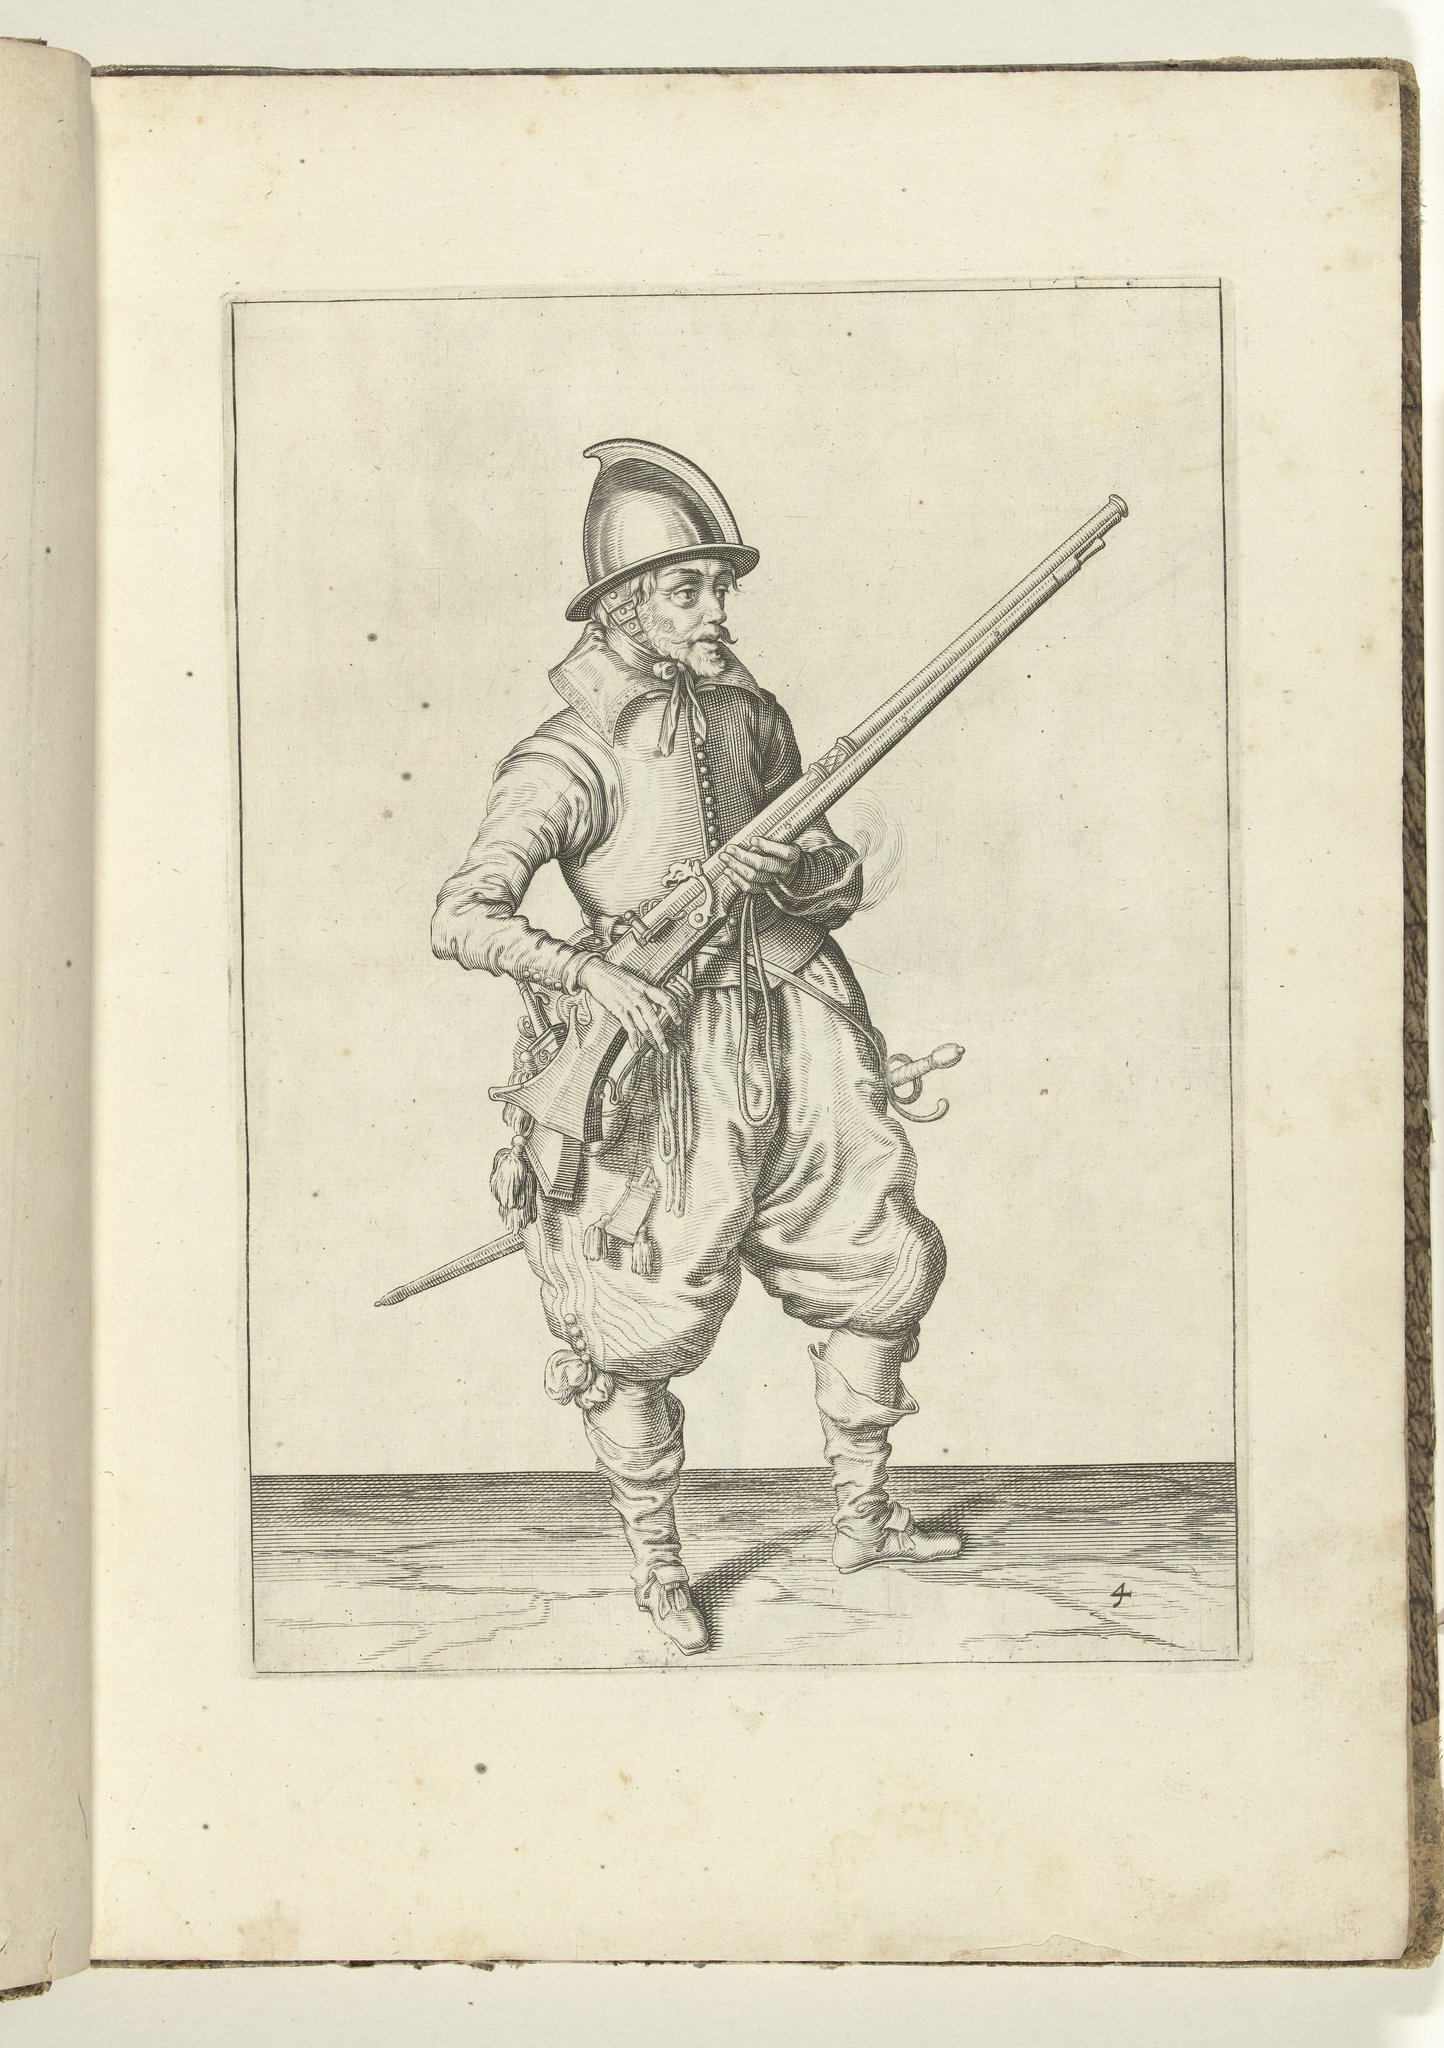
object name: print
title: Soldaat die zijn roer met zijn linkerhand bij zijn rechterzijde vasthoudt (nr. 4), ca. 1600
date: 1597-1608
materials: paper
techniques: engraving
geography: amsterdam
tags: maurice (prince of orange), handling of weapons ~ military training, weapons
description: Een soldaat, ten voeten uit, naar rechts, die een roer (een bepaald type vuurwapen) met zijn linkerhand bij zijn rechterzijde vasthoudt (nr. 4), ca. 1600. In zijn linkerhand behalve het roer ook een brandende lont. Zijn rechterhand losjes bij de trekker van het roer. Plaat 4 in de instructies voor het hanteren van de roer: Brief enseignement, sur la representation des figures, du droit maniement de l'Harquebuse. Onderdeel van de illustraties in een Franse editie van J. de Gheyns Wapenhandelinghe: J. de Gheyn, Maniement d'armes, d'arquebuses, mousquetz et piques : en conformité de l'ordre de Mour le Prince Maurice, Prince d'Orange, Amsterdam 1608. Krijgswezen rond 1600.